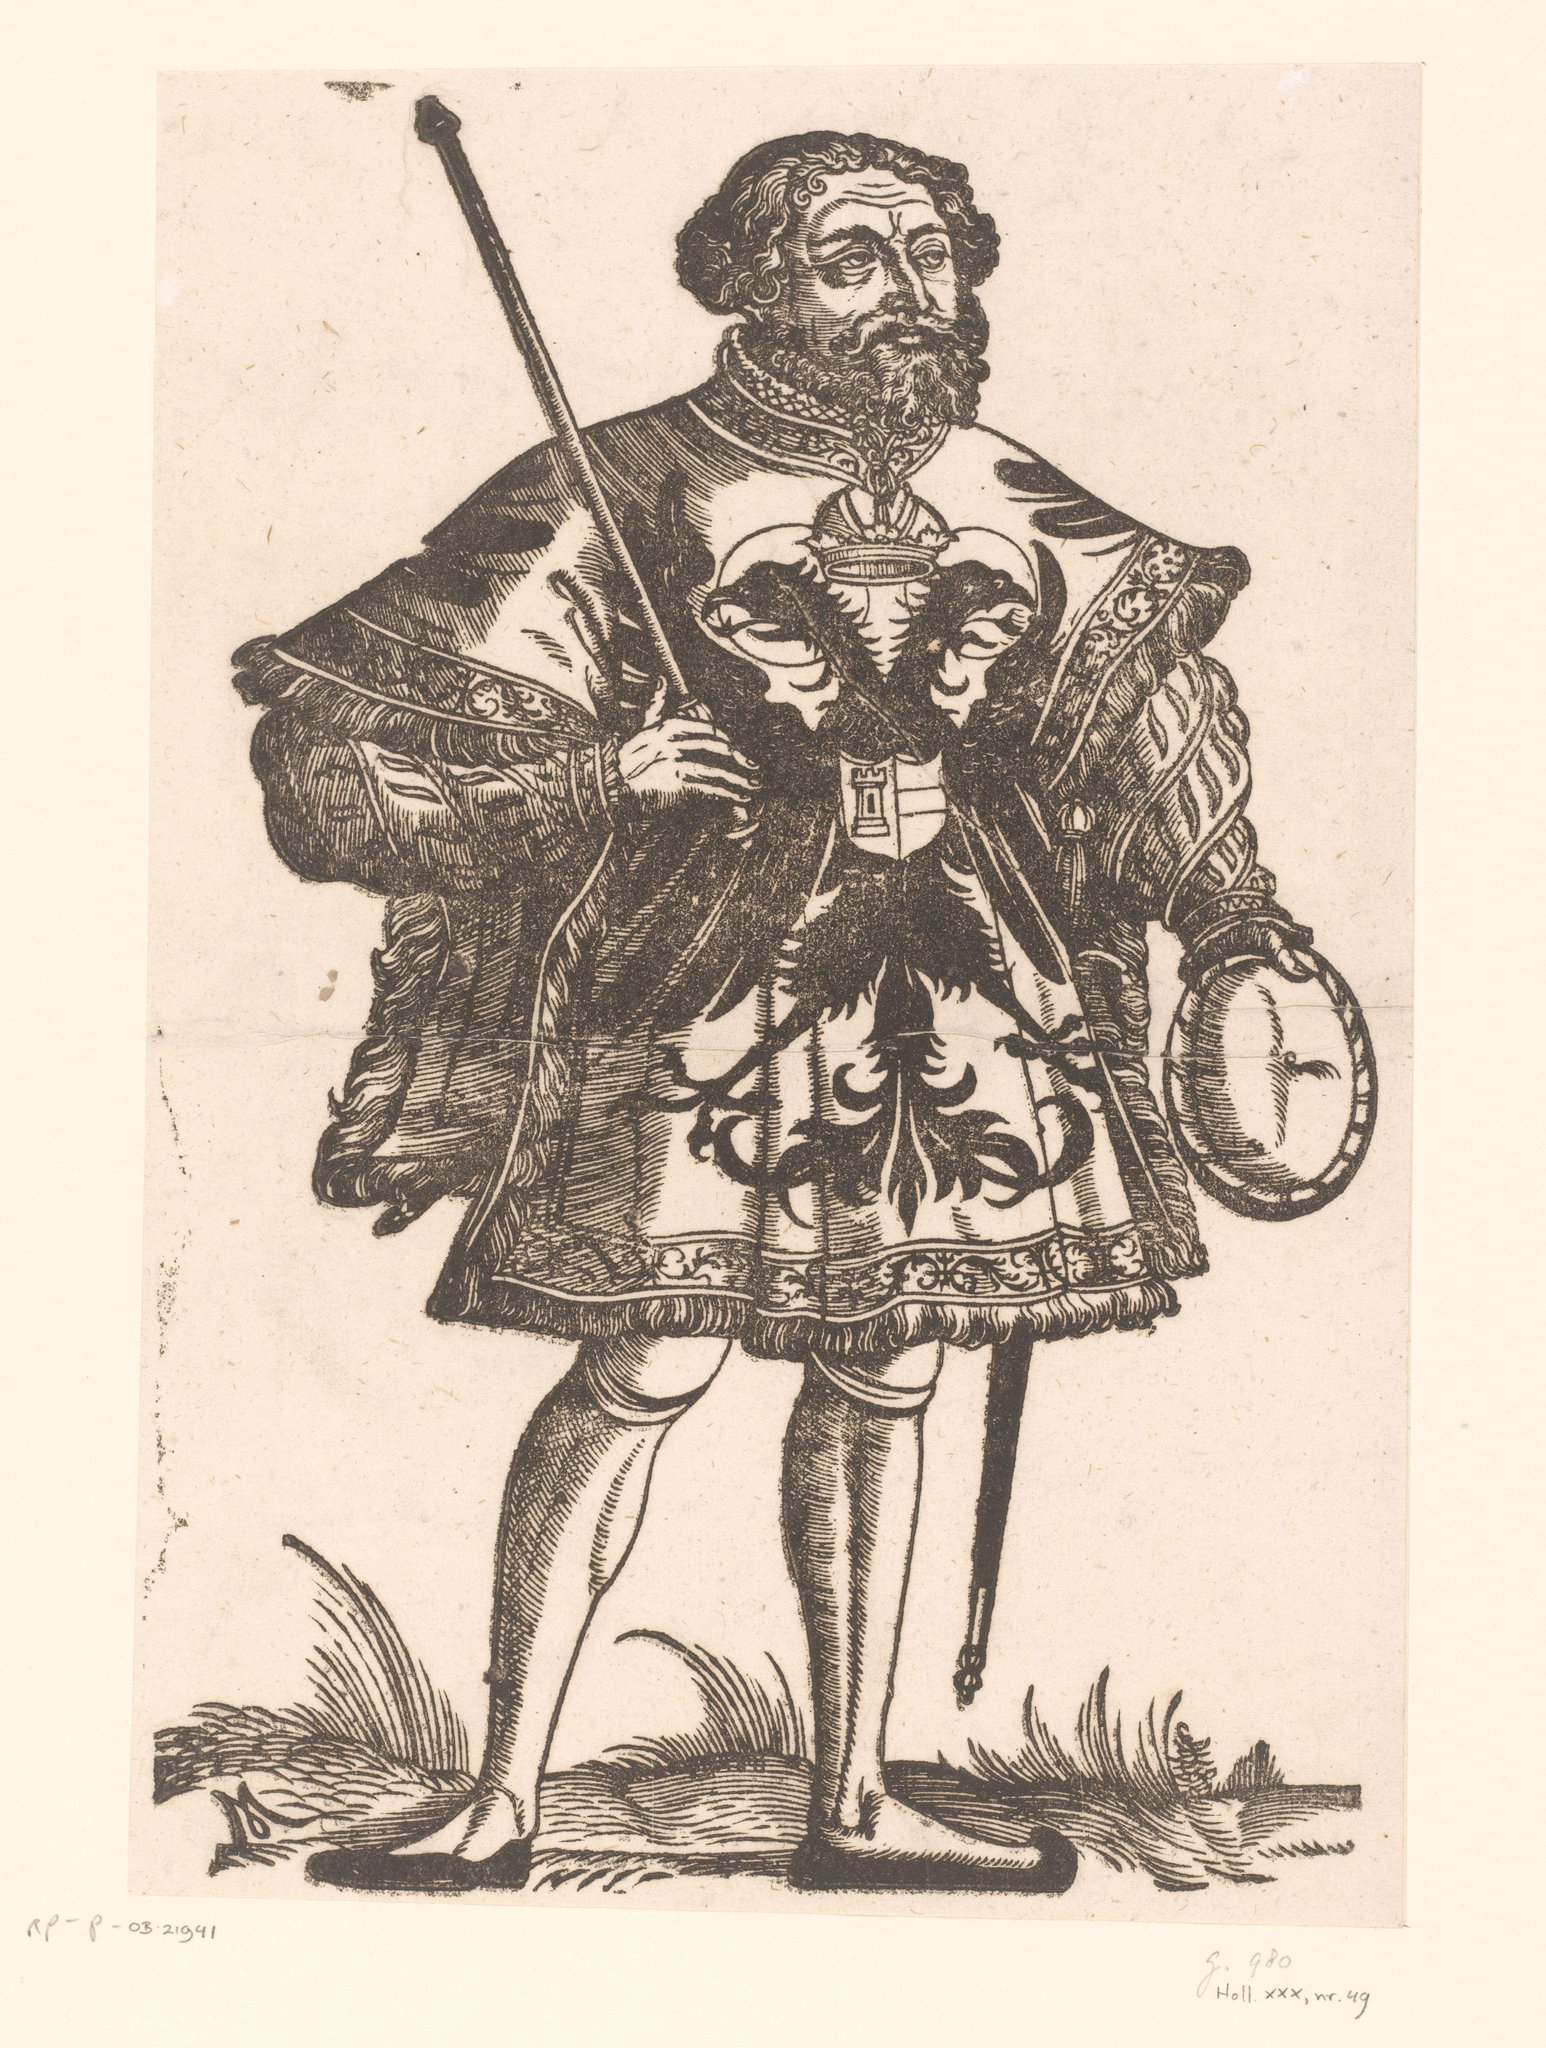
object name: print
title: Duitse heraut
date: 1500-1559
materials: paper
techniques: woodcut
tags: herald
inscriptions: verso, gestempeld